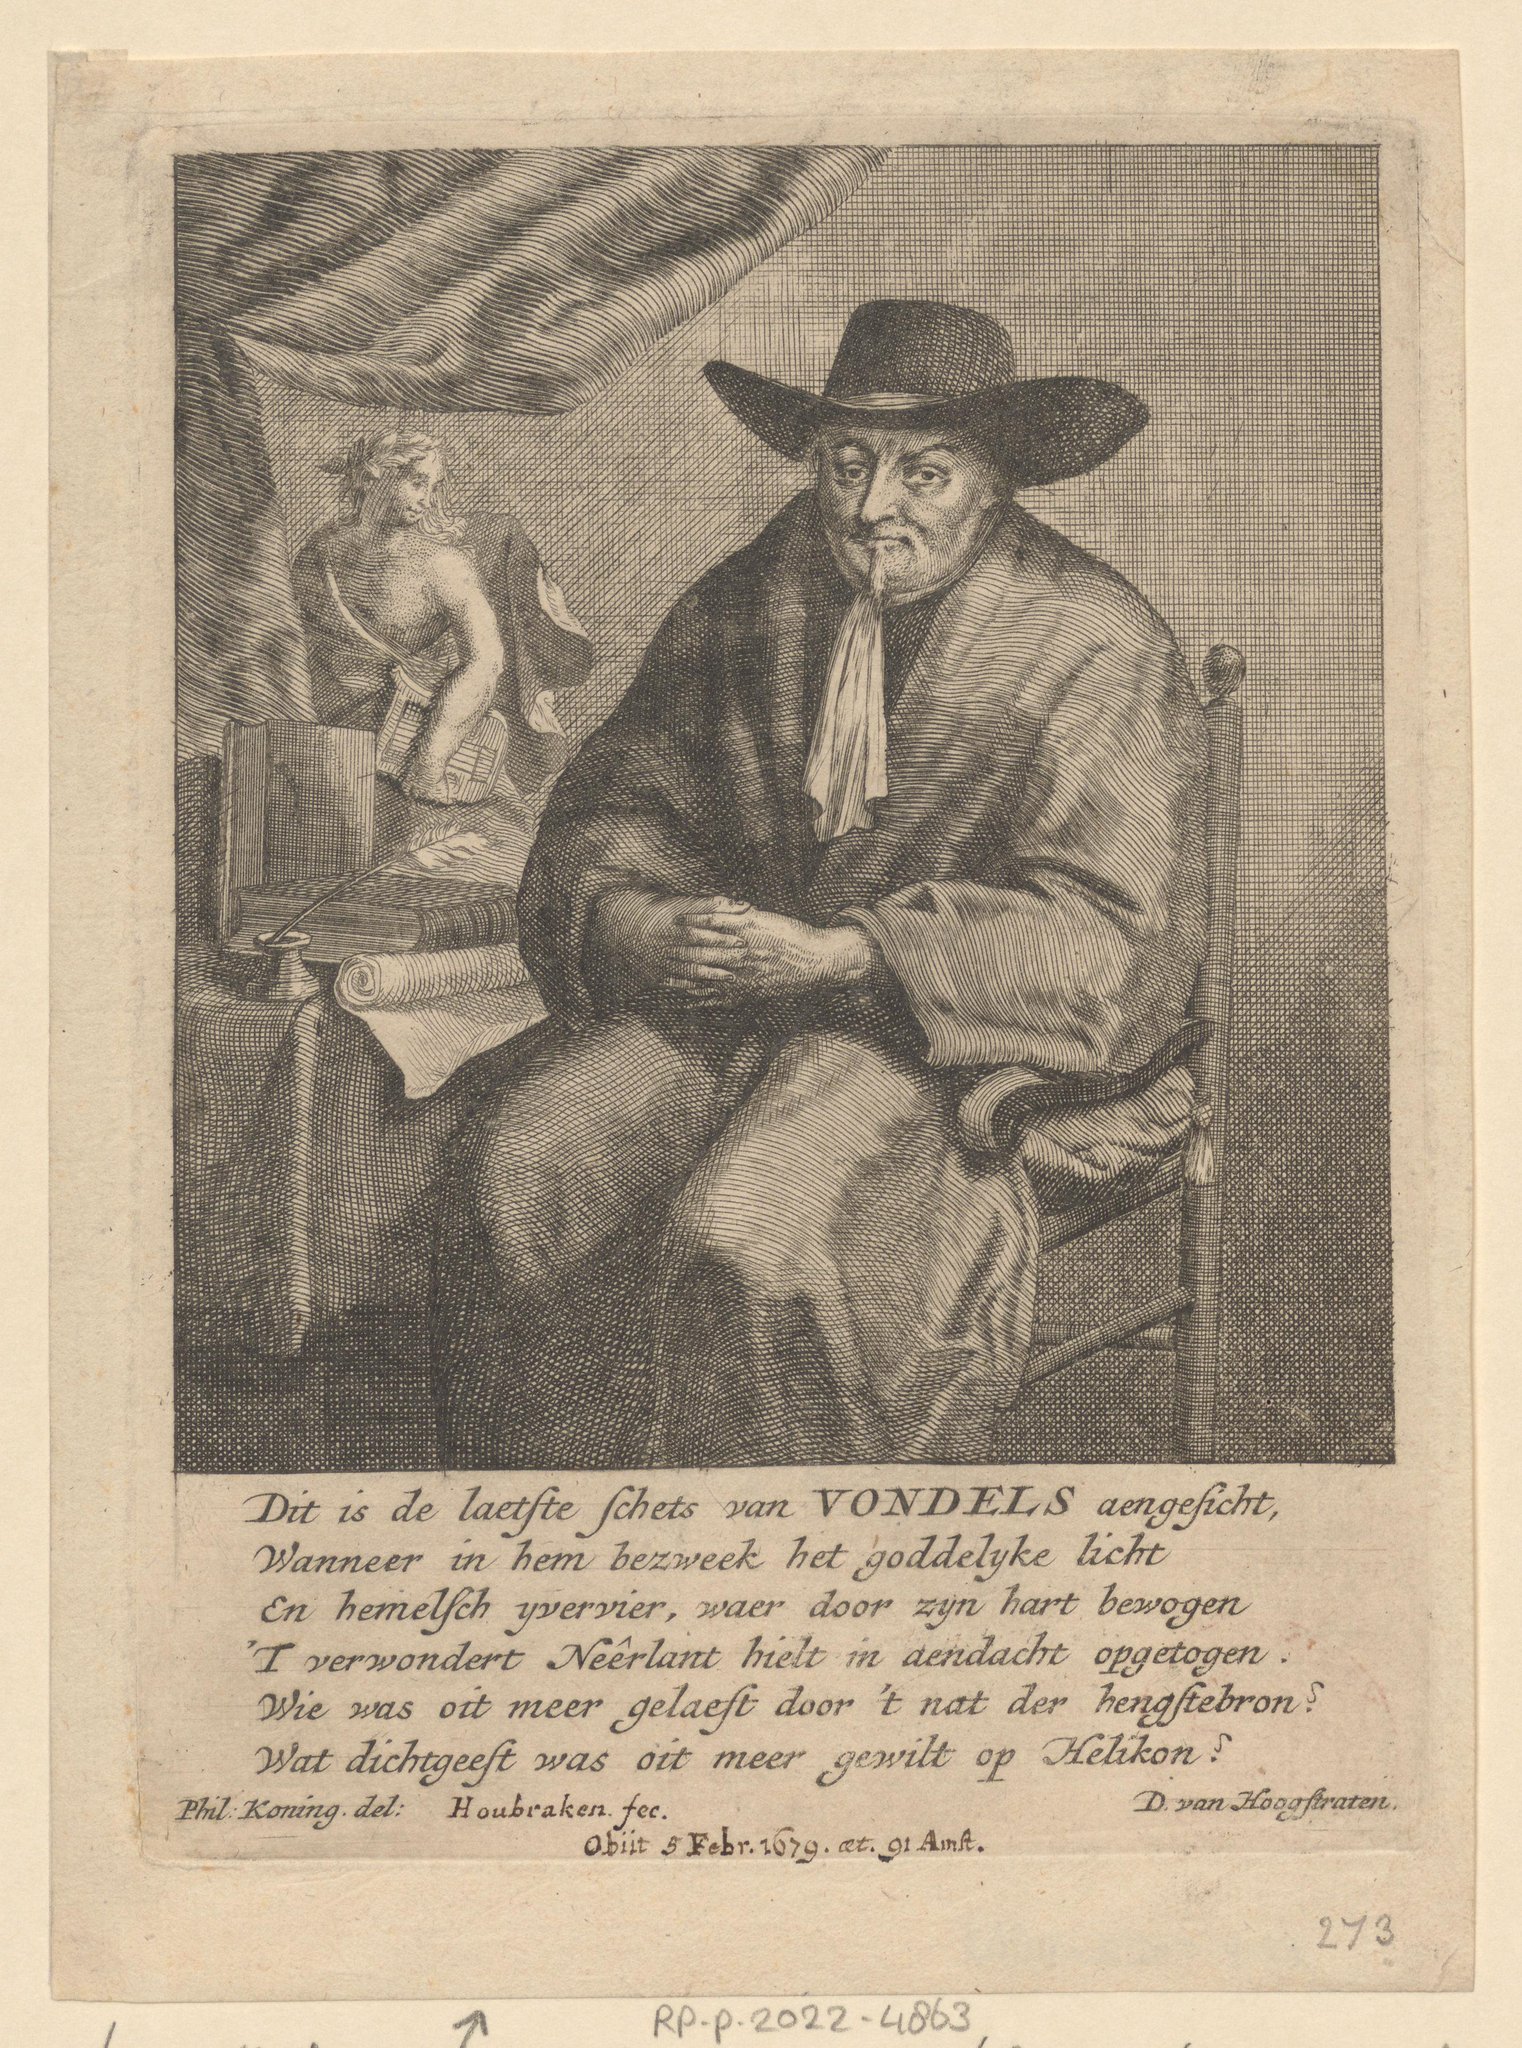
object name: print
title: Portret van Joost van den Vondel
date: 1716-1730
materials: paper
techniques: etching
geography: amsterdam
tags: cologne, amsterdam, joost van den vondel, historical persons, portrait of a writer, writer, poet, author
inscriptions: collector's mark: Lugt 240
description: Prent waarschijnlijk uit: Ovidius, en Vondel, Joost van den. Nasoos Heldinnebrieven. Amsterdam: Gerard onder de Linden, 1715. Prent ook gebruikt in de editie uit 1730.